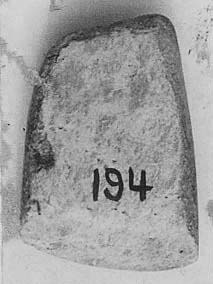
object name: knife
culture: swiss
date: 1902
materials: jade